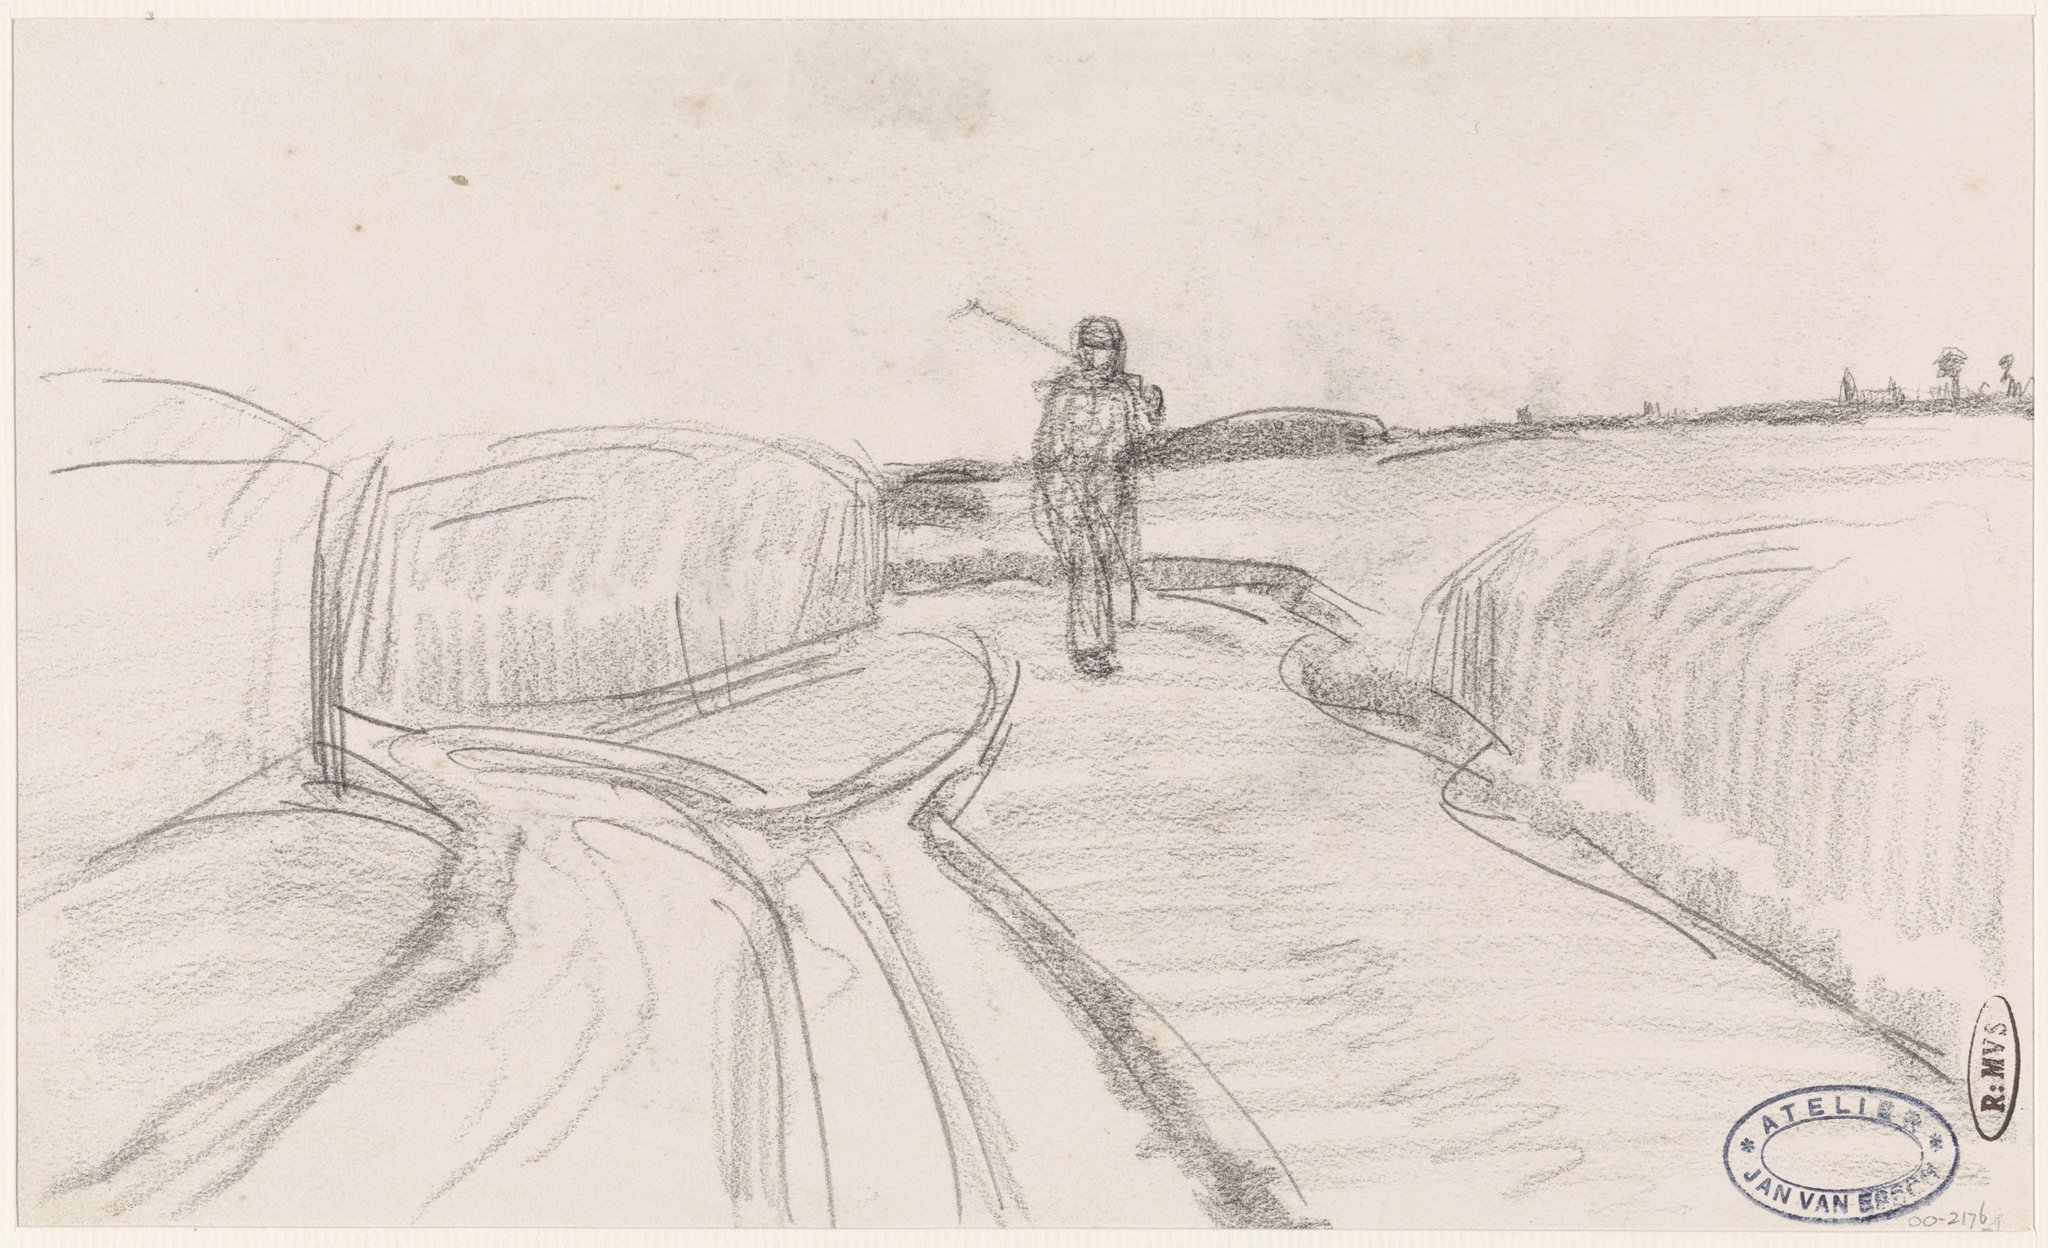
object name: drawing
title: Boer tussen velden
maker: jan van essen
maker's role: draughtsman, print maker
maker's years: 1854-1936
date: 1864-1936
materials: chalk, paper